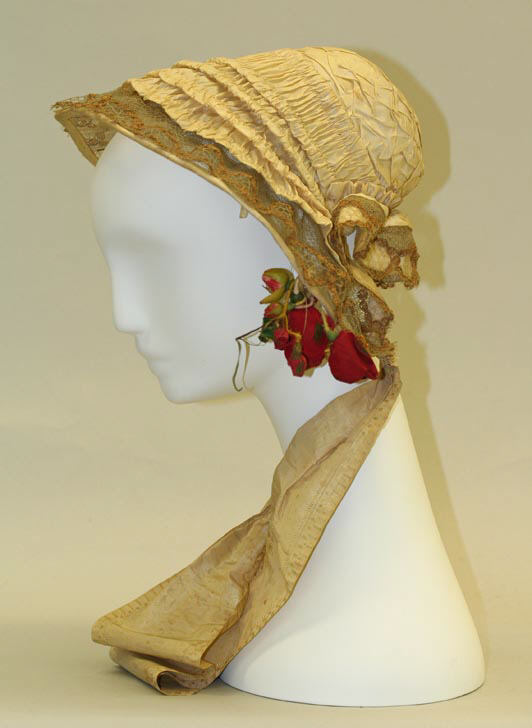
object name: poke bonnet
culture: american or european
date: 1840-1869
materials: silk